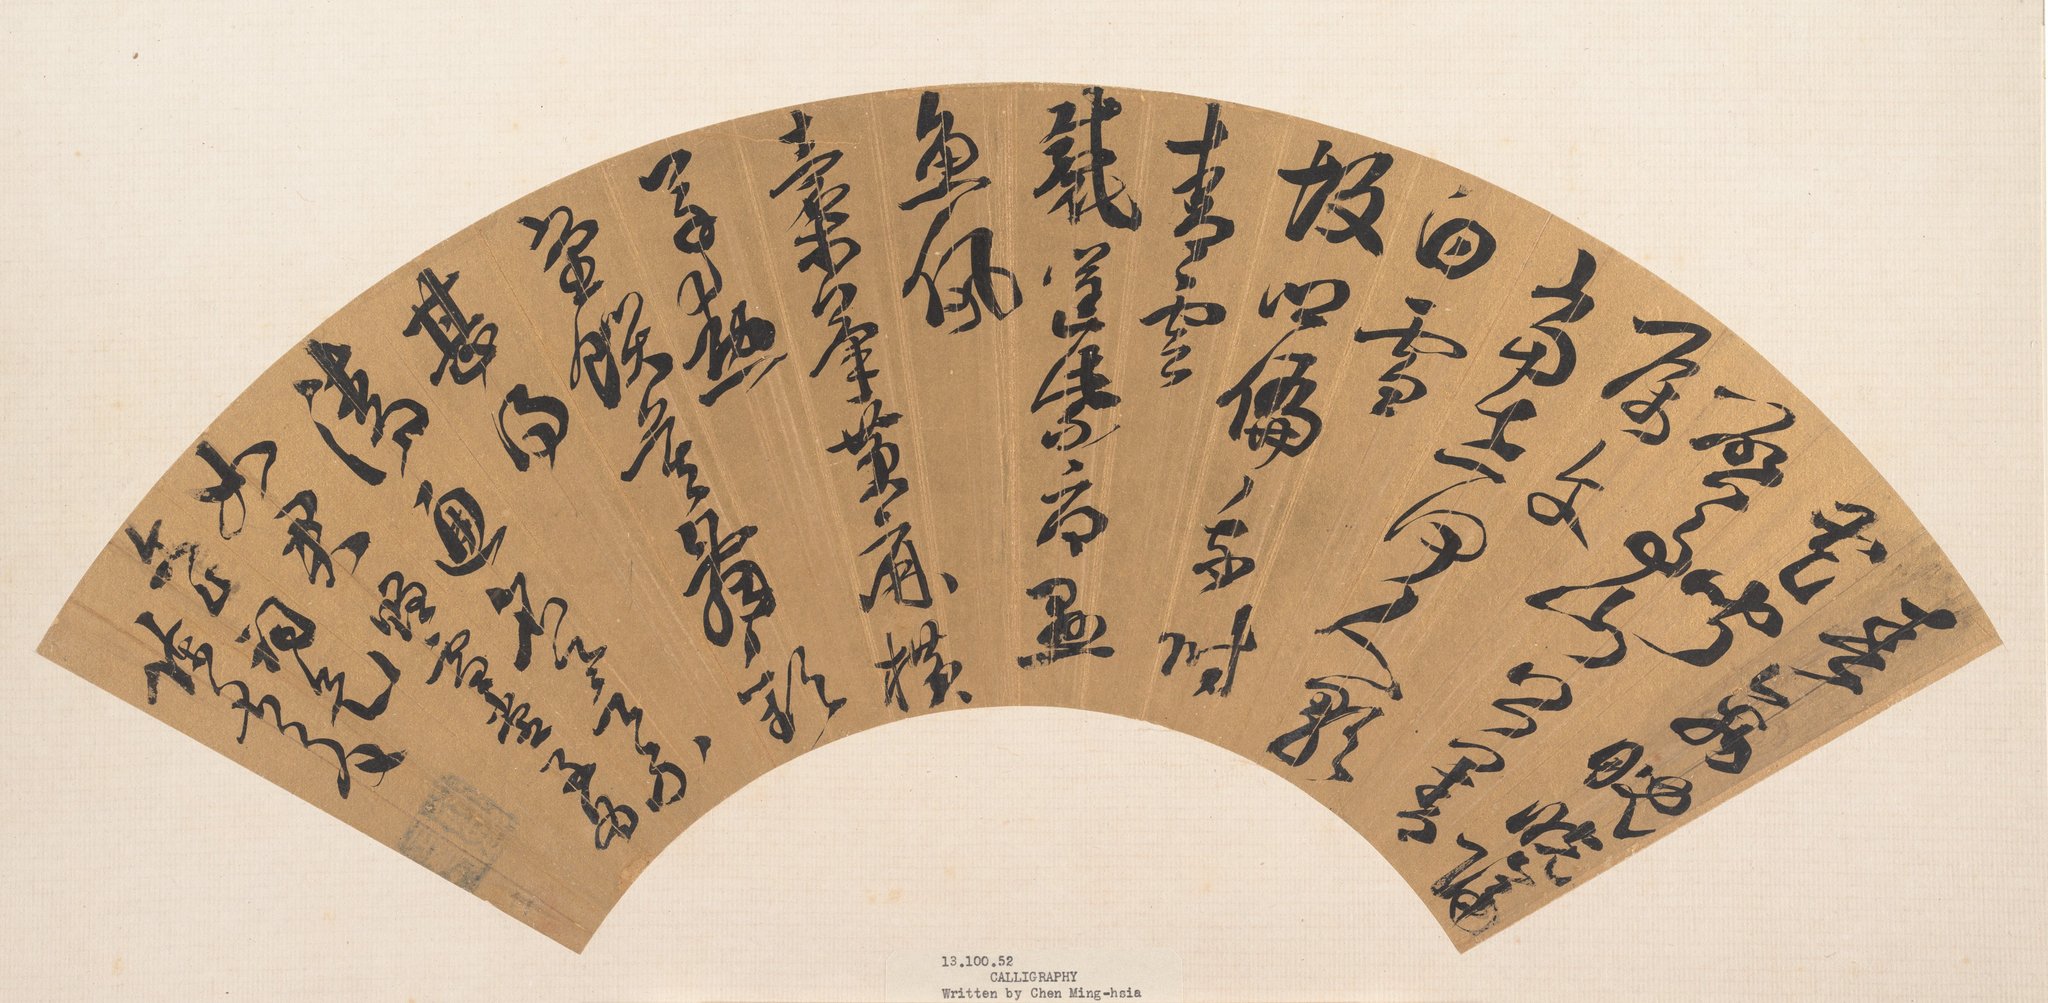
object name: folding fan mounted a an album leaf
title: Calligraphy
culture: chinese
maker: chen mingxia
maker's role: artist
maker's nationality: chinese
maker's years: 1601-1654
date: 1601-1654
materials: ink, paper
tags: calligraphy